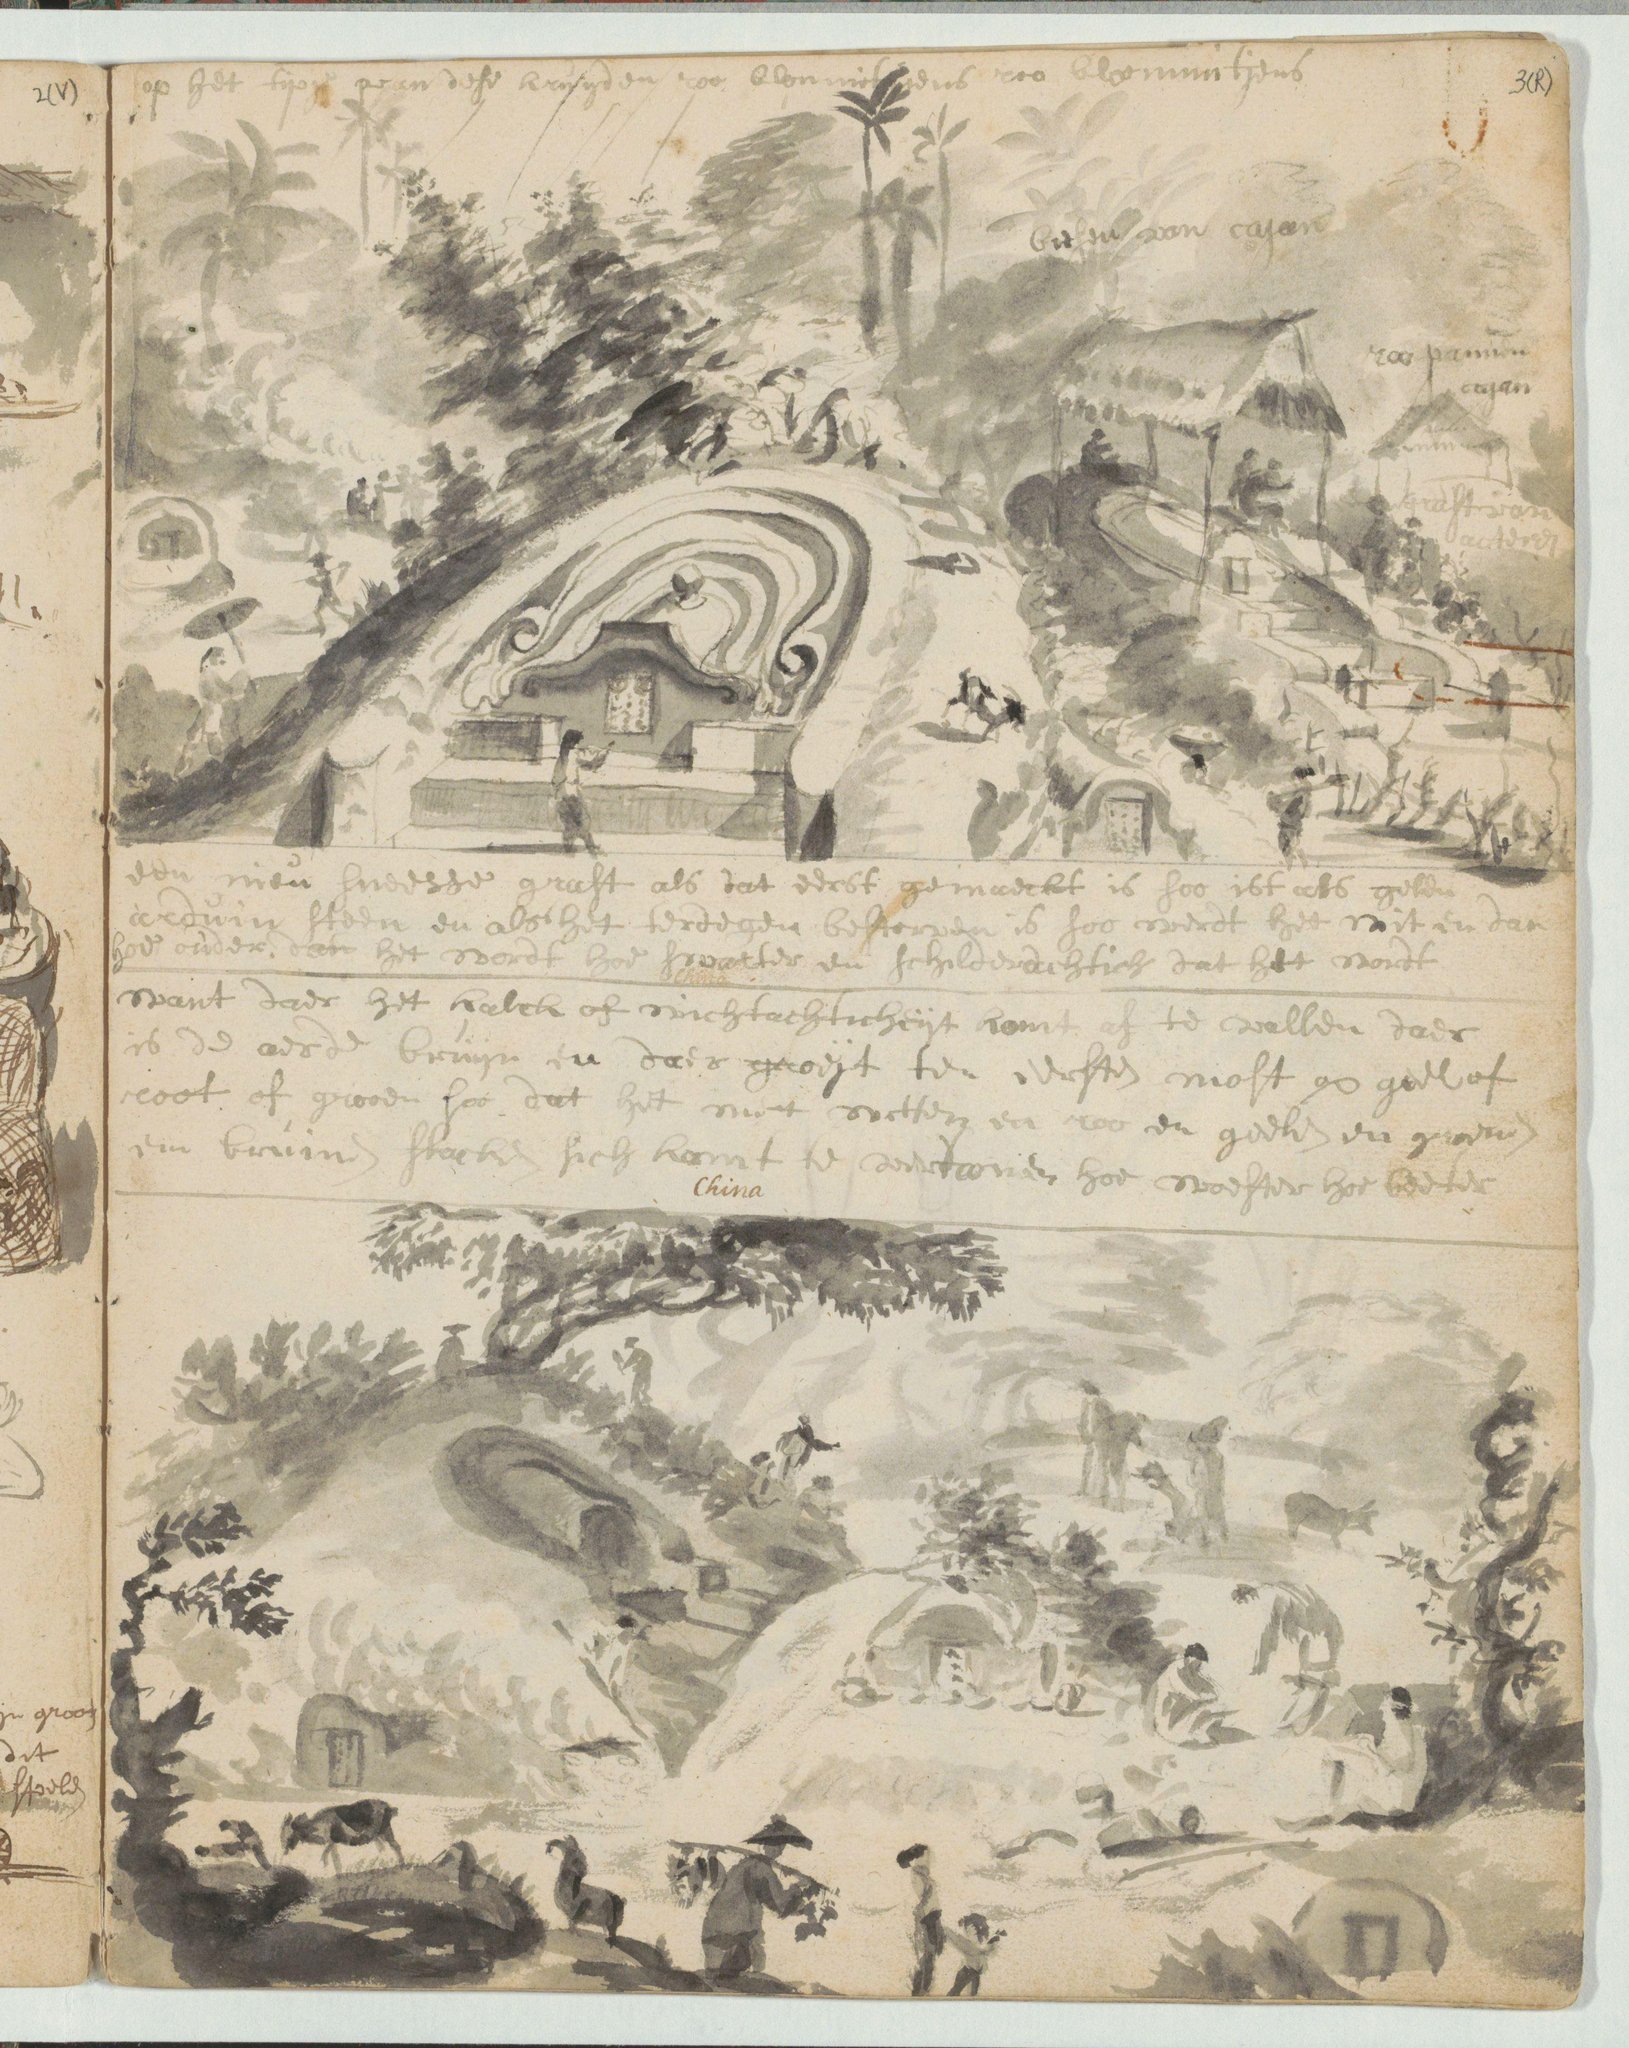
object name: sketchbook leaf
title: Chinese begraafplaatsen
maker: wouter schouten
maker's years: 1638-1704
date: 1660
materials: ink, paper, pencil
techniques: brush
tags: asiatic races and peoples (with name), landscape with other man-made constructions not mentioned above, e.g.: graveyards, playgrounds, etc., landscapes (+ landscape with figures, staffage), china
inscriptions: annotation: ‘[...]/ China/ [...]’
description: Blad 3 recto van een katern van 10 bladen afkomstig uit een schetsboek.